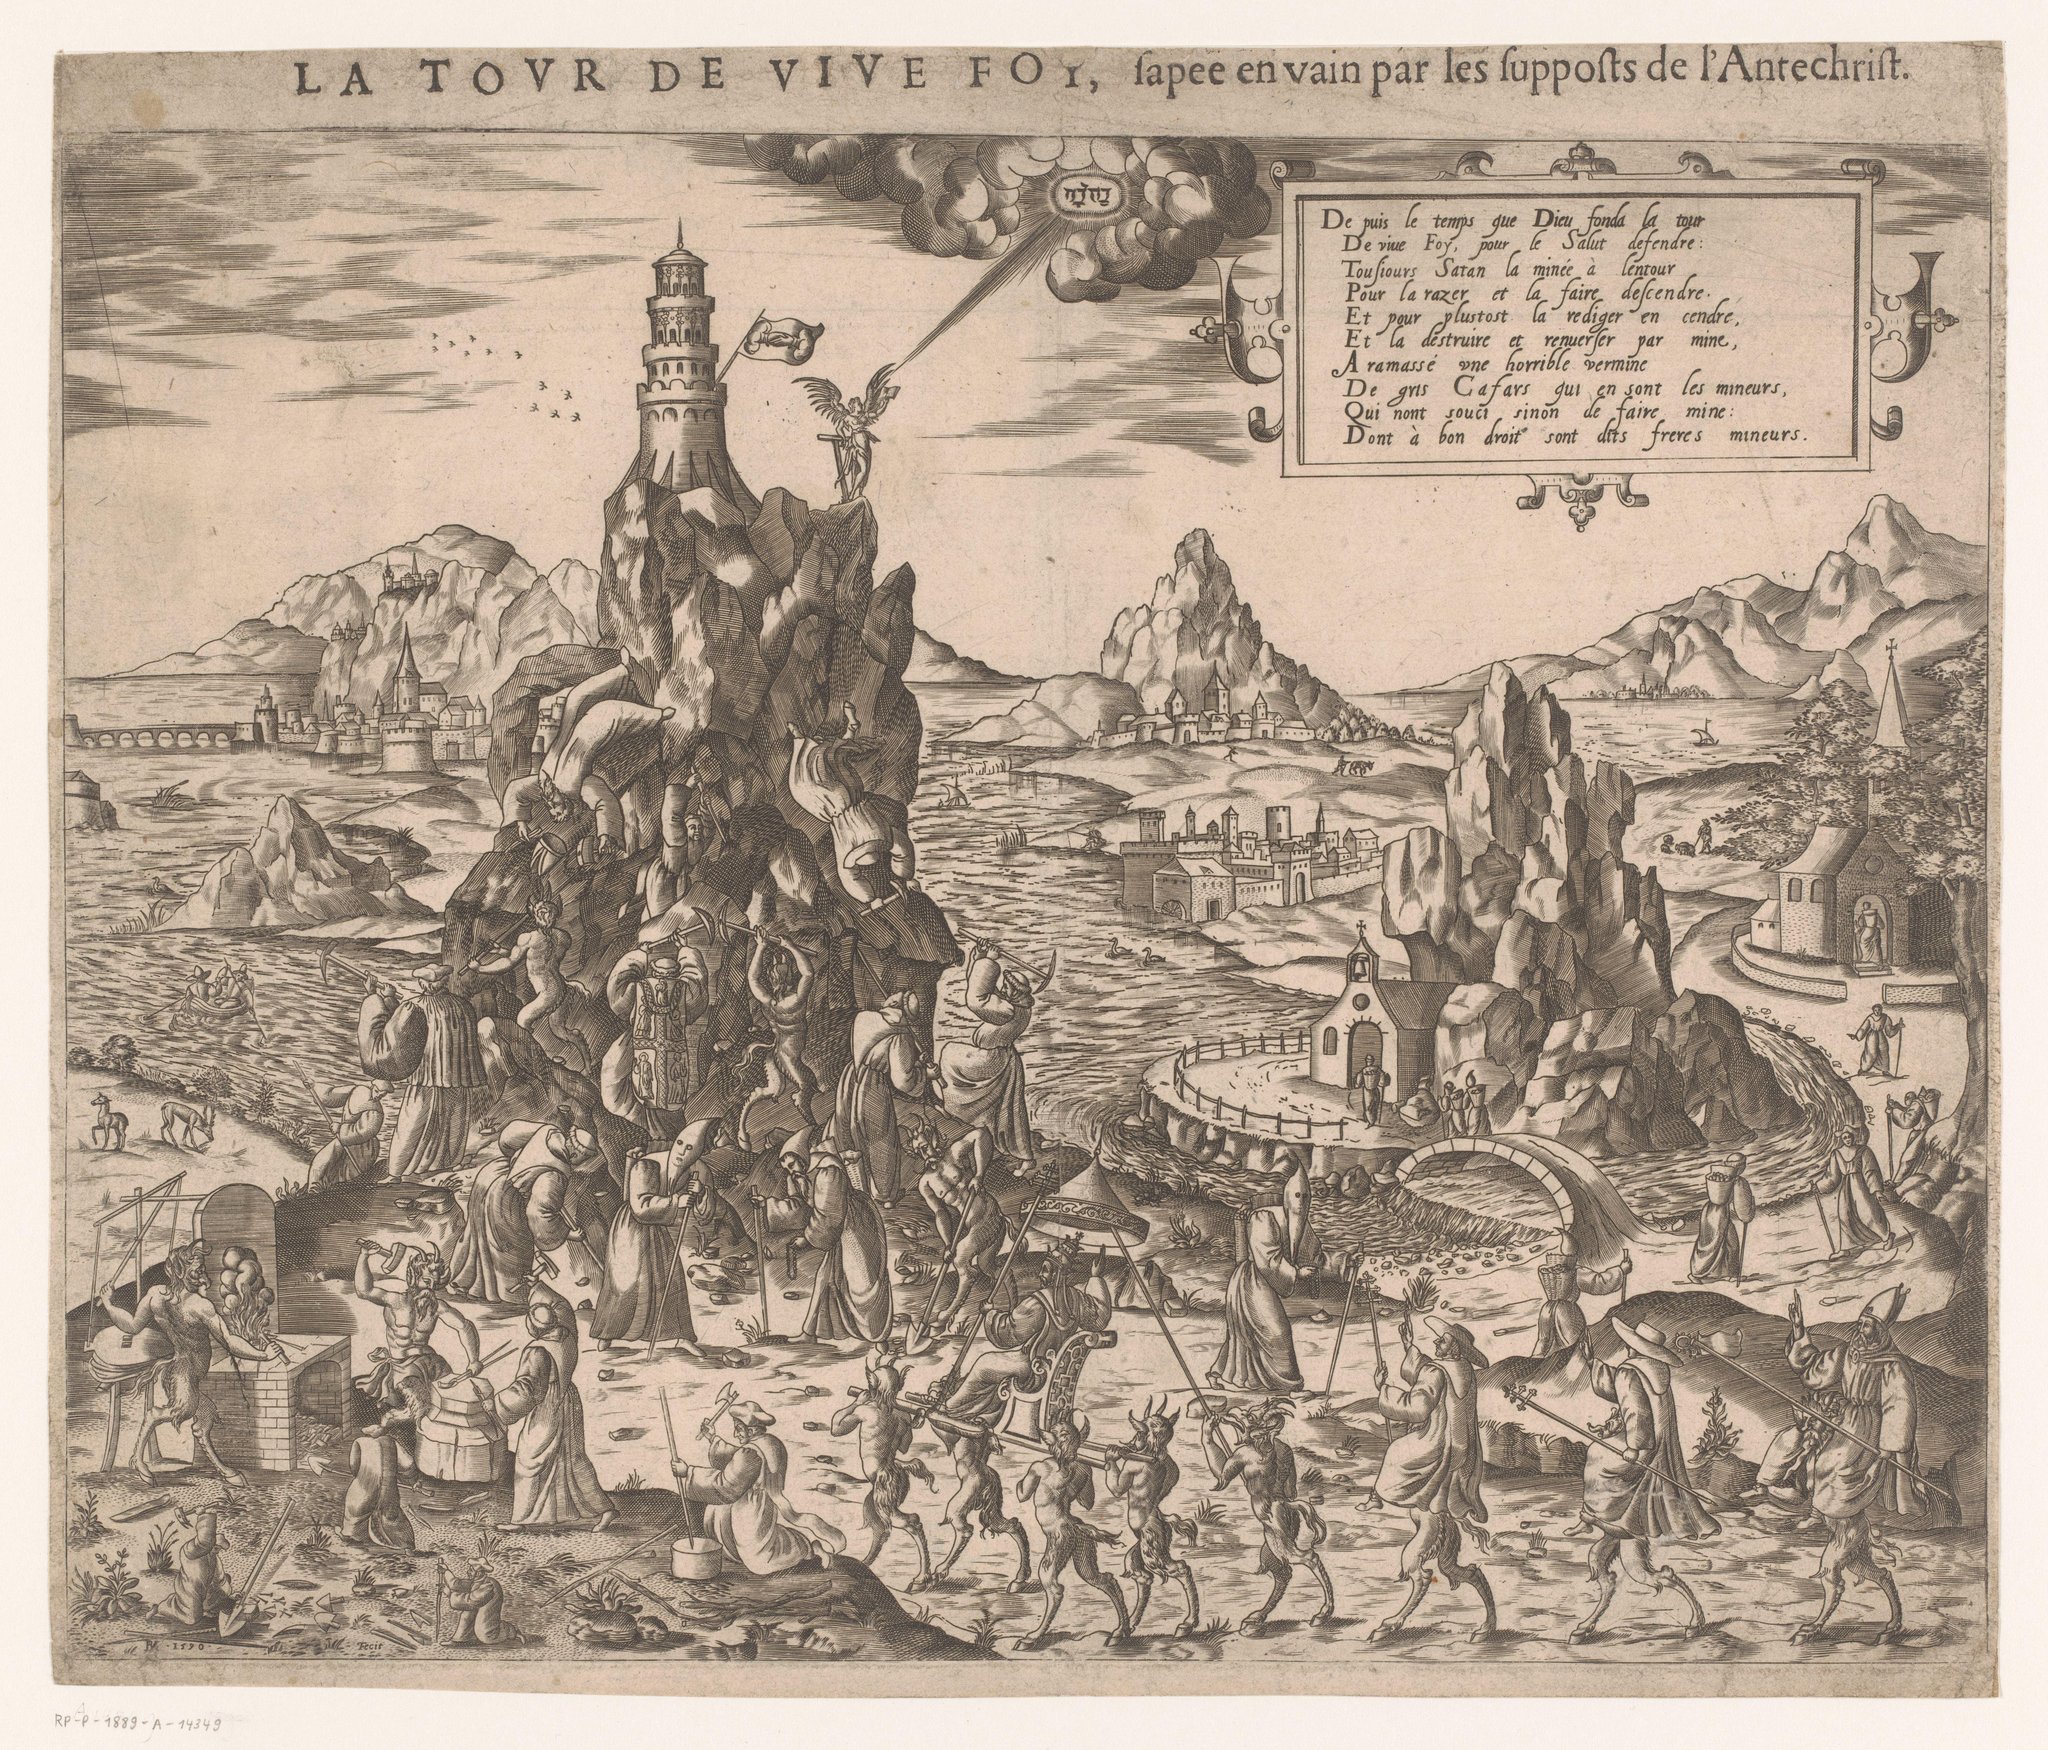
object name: print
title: Aanval op de toren van het geloof en de komst van de Antichrist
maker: monogrammist pm (16e eeuw)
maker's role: print maker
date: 1590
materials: paper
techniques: engraving, etching, letterpress printing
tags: landscape with tower or castle, antichrist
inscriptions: collector's mark: Lugt 2228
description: Links op een rots de toren van het geloof. Een menigte geestelijken tracht met houwelen en hamers de toren af te breken.